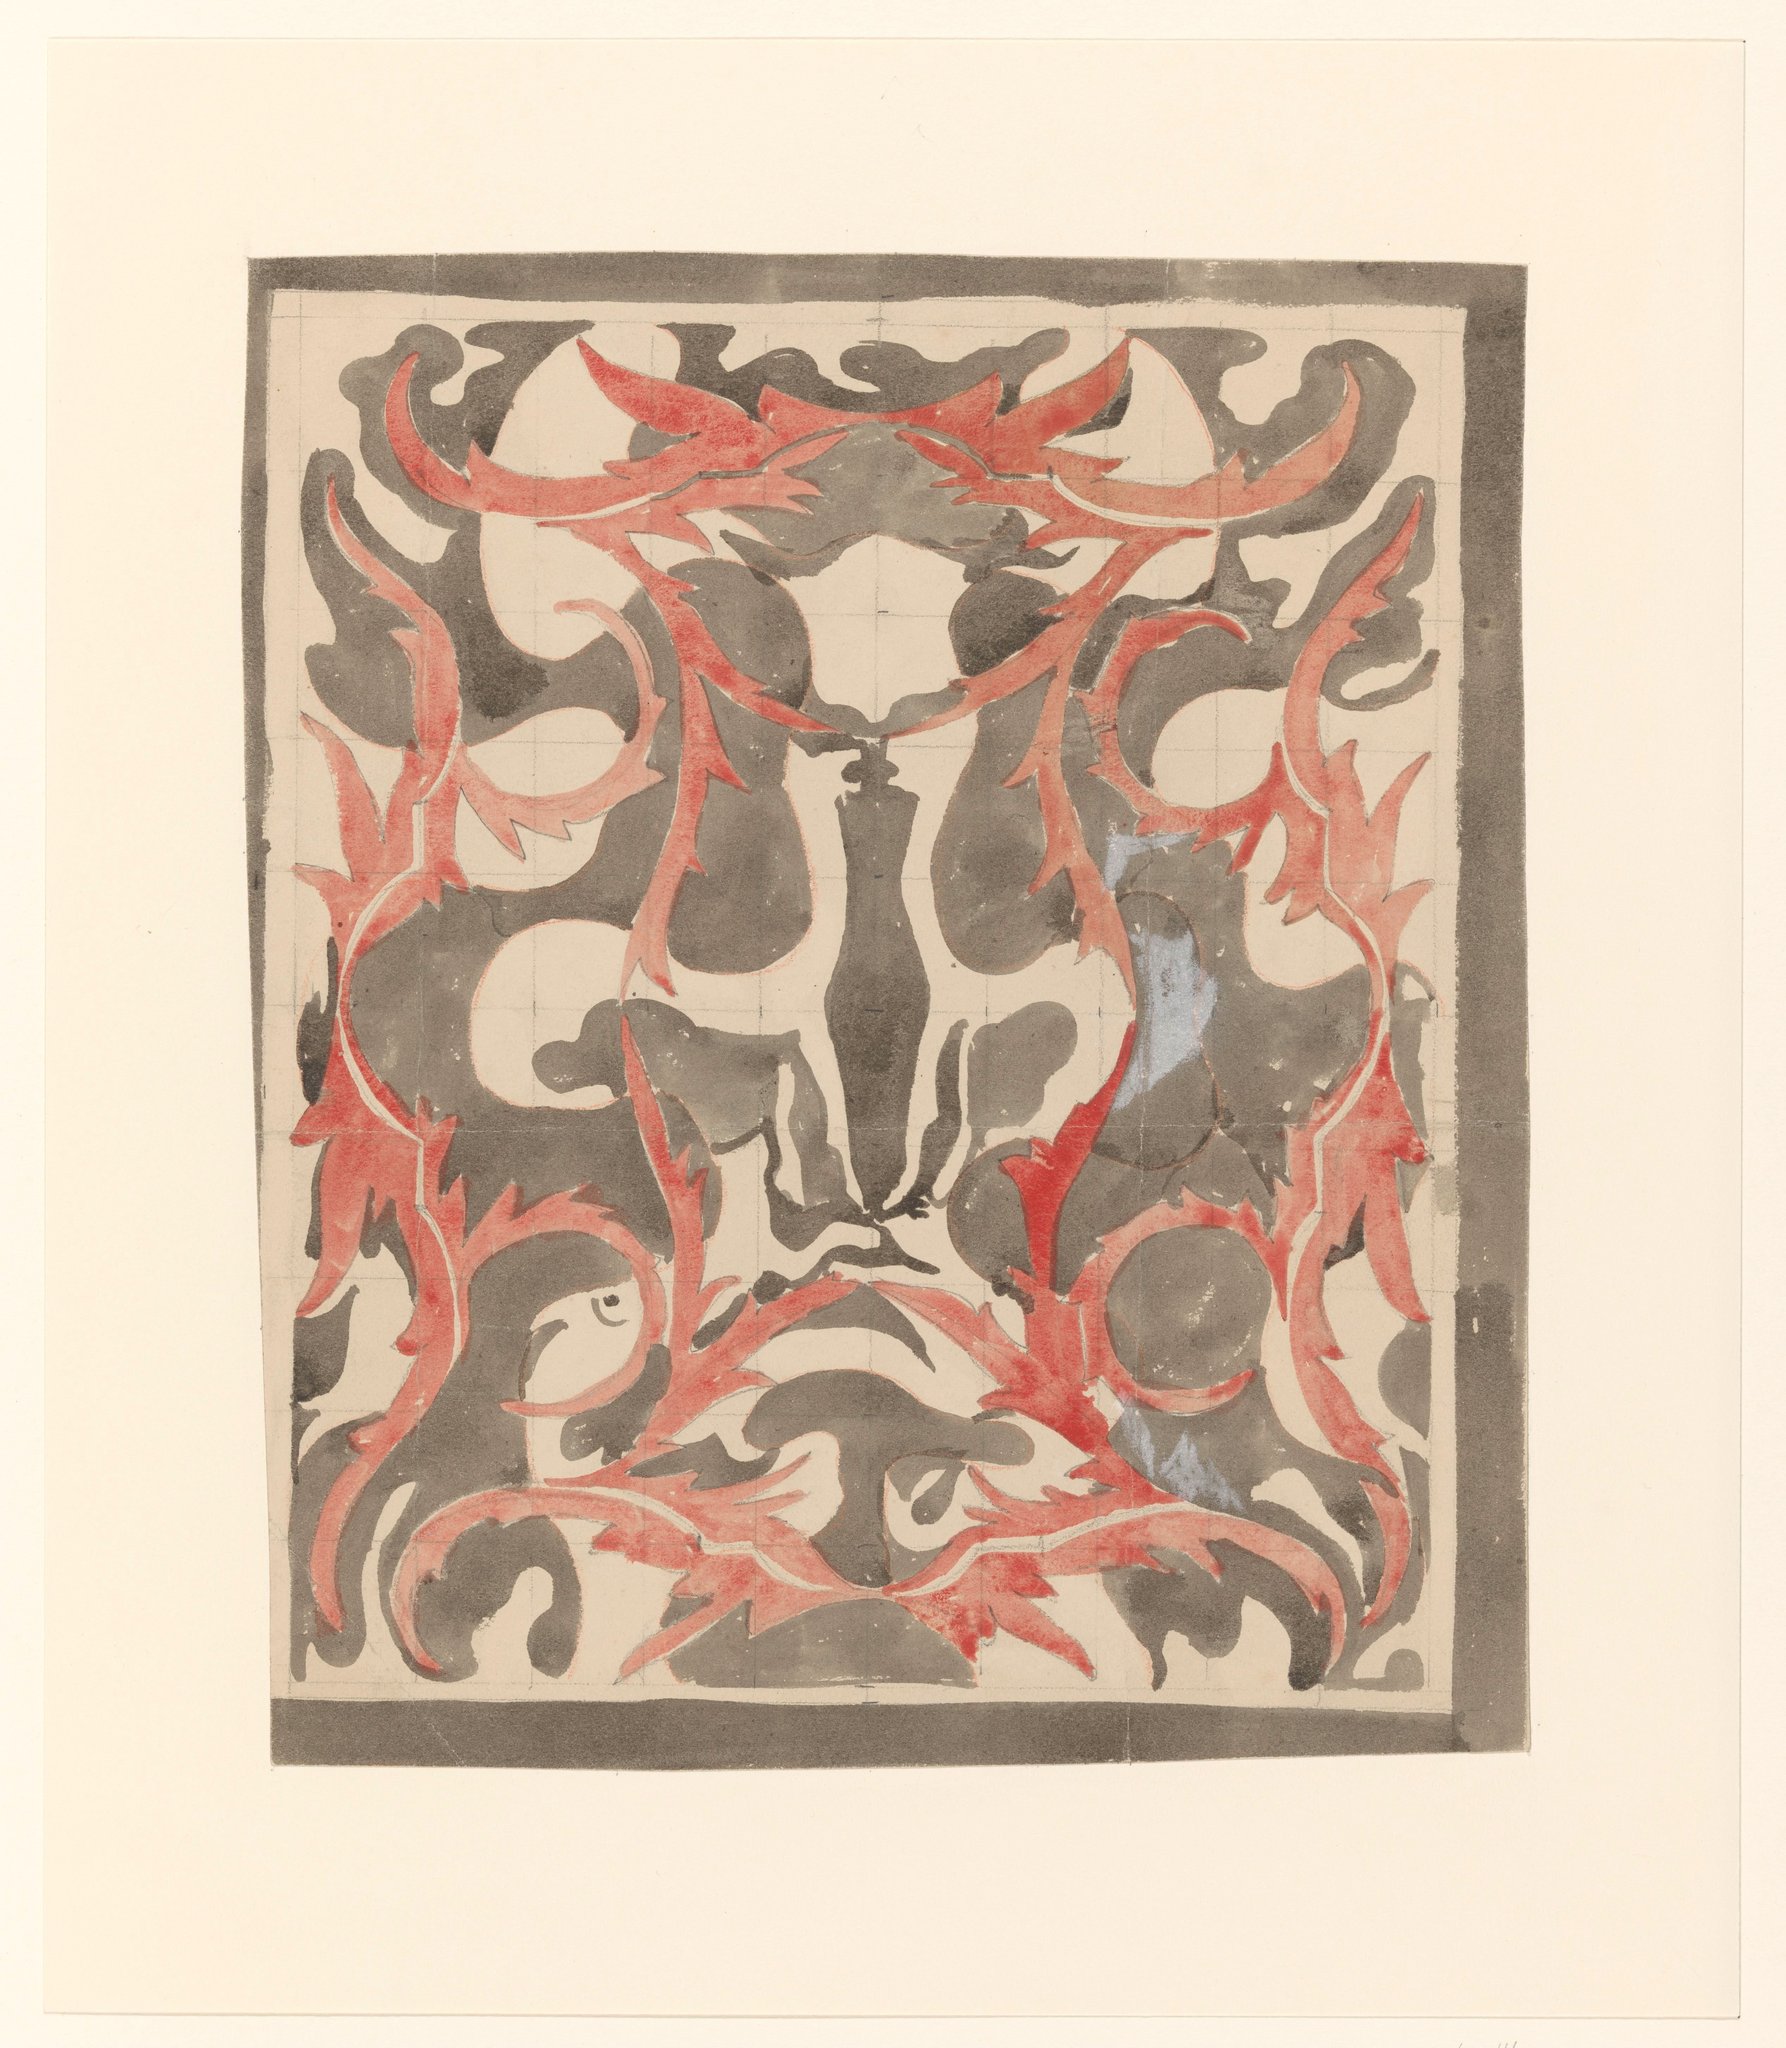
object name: design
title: Decoratief ontwerp met diermotieven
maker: carel adolph lion cachet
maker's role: draughtsman, print maker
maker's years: 1864-1945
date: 1874-1945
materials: paper, pencil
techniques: brush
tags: ornament derived from animal forms